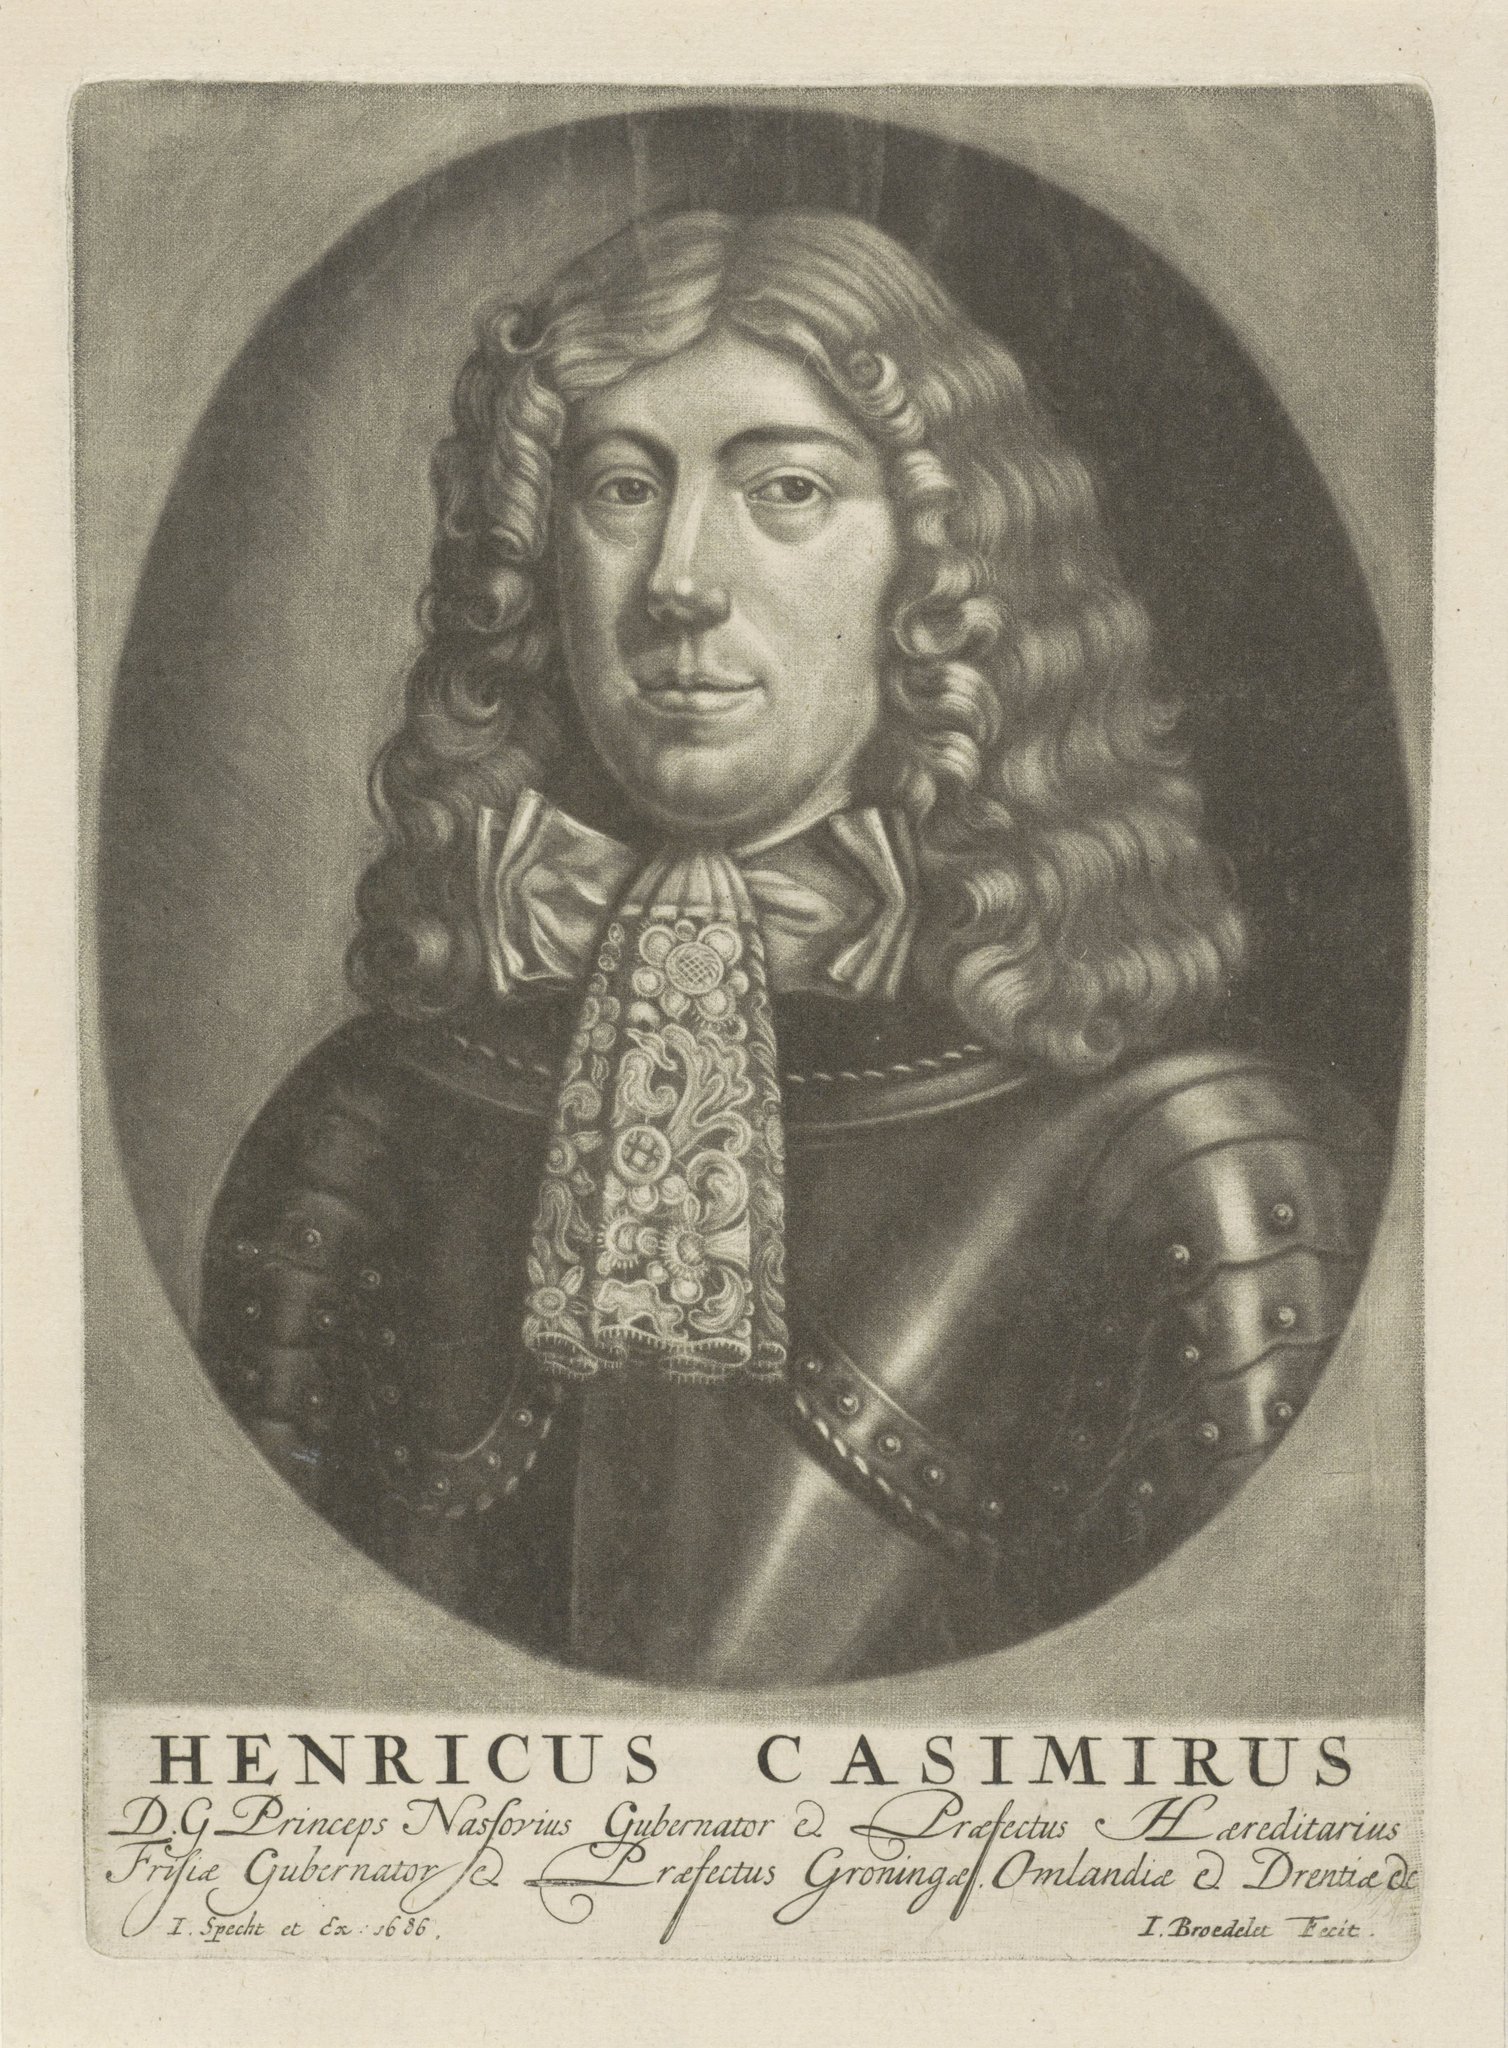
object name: print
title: Portret van Hendrik Casimir II, graaf van Nassau-Dietz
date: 1686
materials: paper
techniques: mezzotint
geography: utrecht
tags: the hague, hendrik casimir ii graaf van nassau-dietz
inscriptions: collector's mark: Lugt 2228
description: De hier vermelde titel verwijst naar de hoogst verkregen titel van de geportretteerde, niet per se naar de titel die de geportretteerde op deze voorstelling draagt.